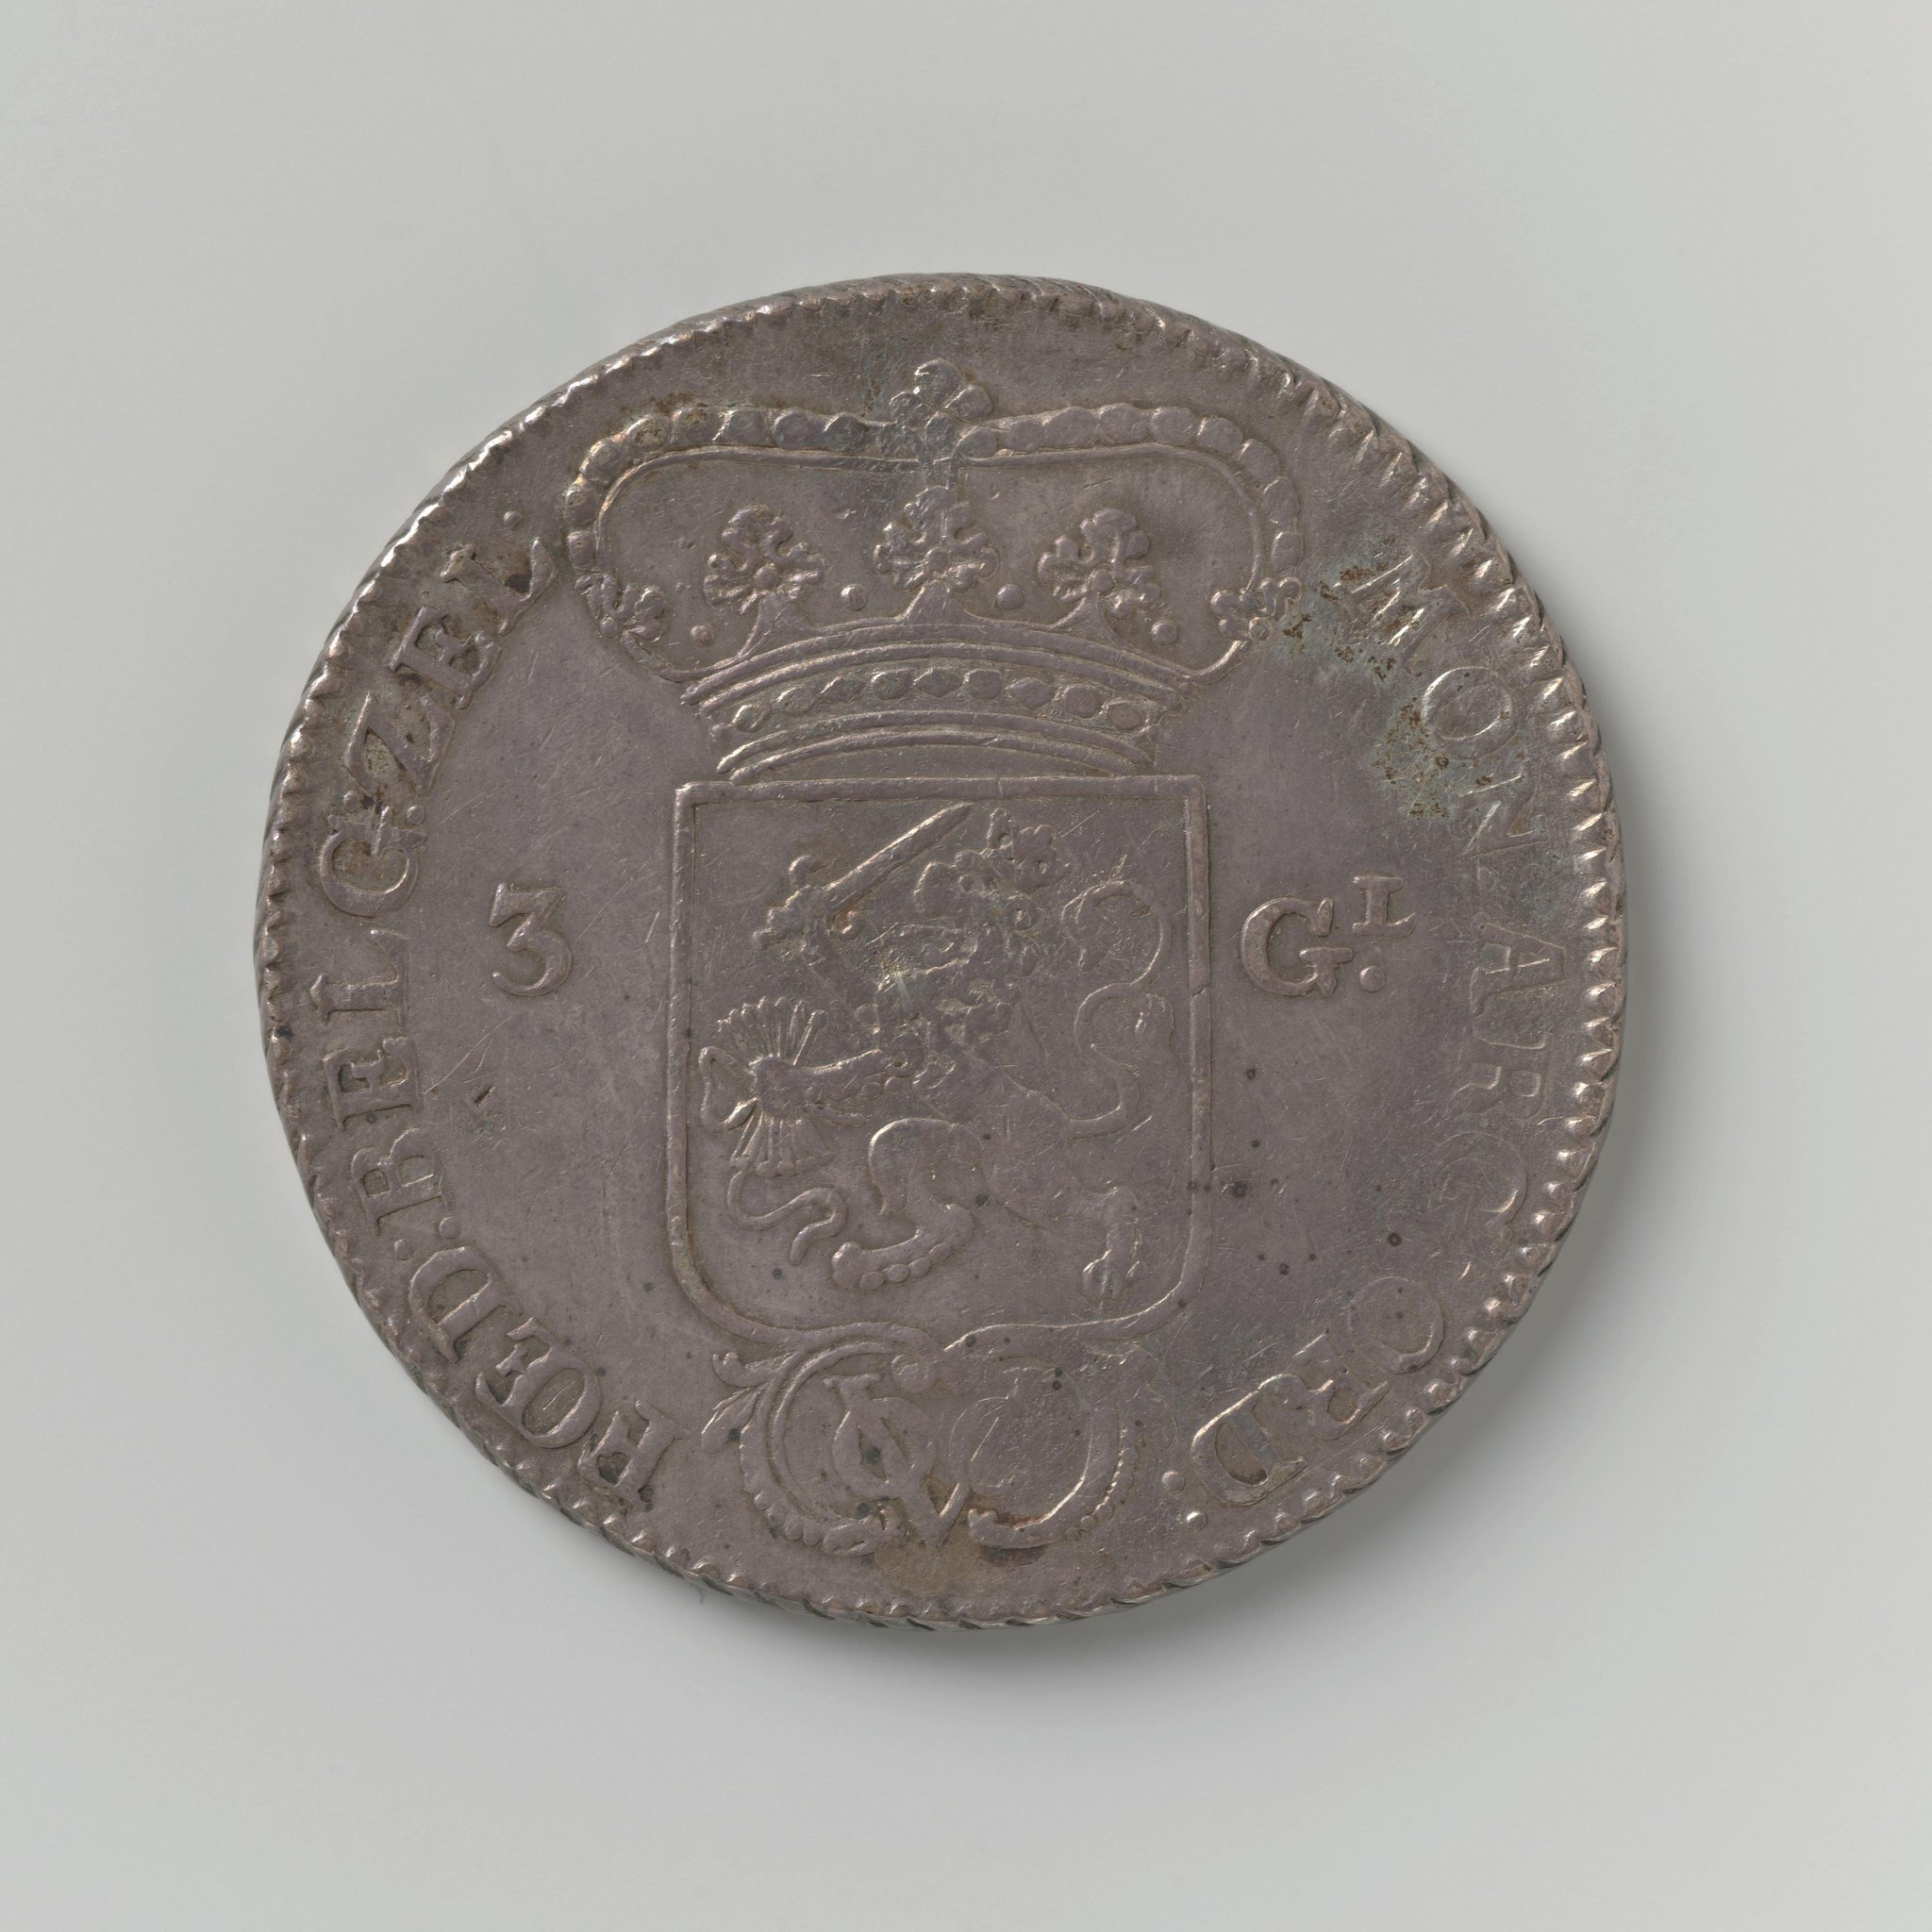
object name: coin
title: Drie gulden van de VOC uit Zeeland, 1789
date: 1789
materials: silver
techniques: striking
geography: middelburg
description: Zilveren munt. Voorzijde: tussen waarde-aanduiding 3 Gl. gekroond generaliteitswapenschild, waaronder cartouche, waarin monogram van de VOC. Keerzijde: Nederlandse maagd met speer, waarop vrijheidshoed, leunend op een bijbel op een altaar. Jaartal in afsnede. Kabelrand.